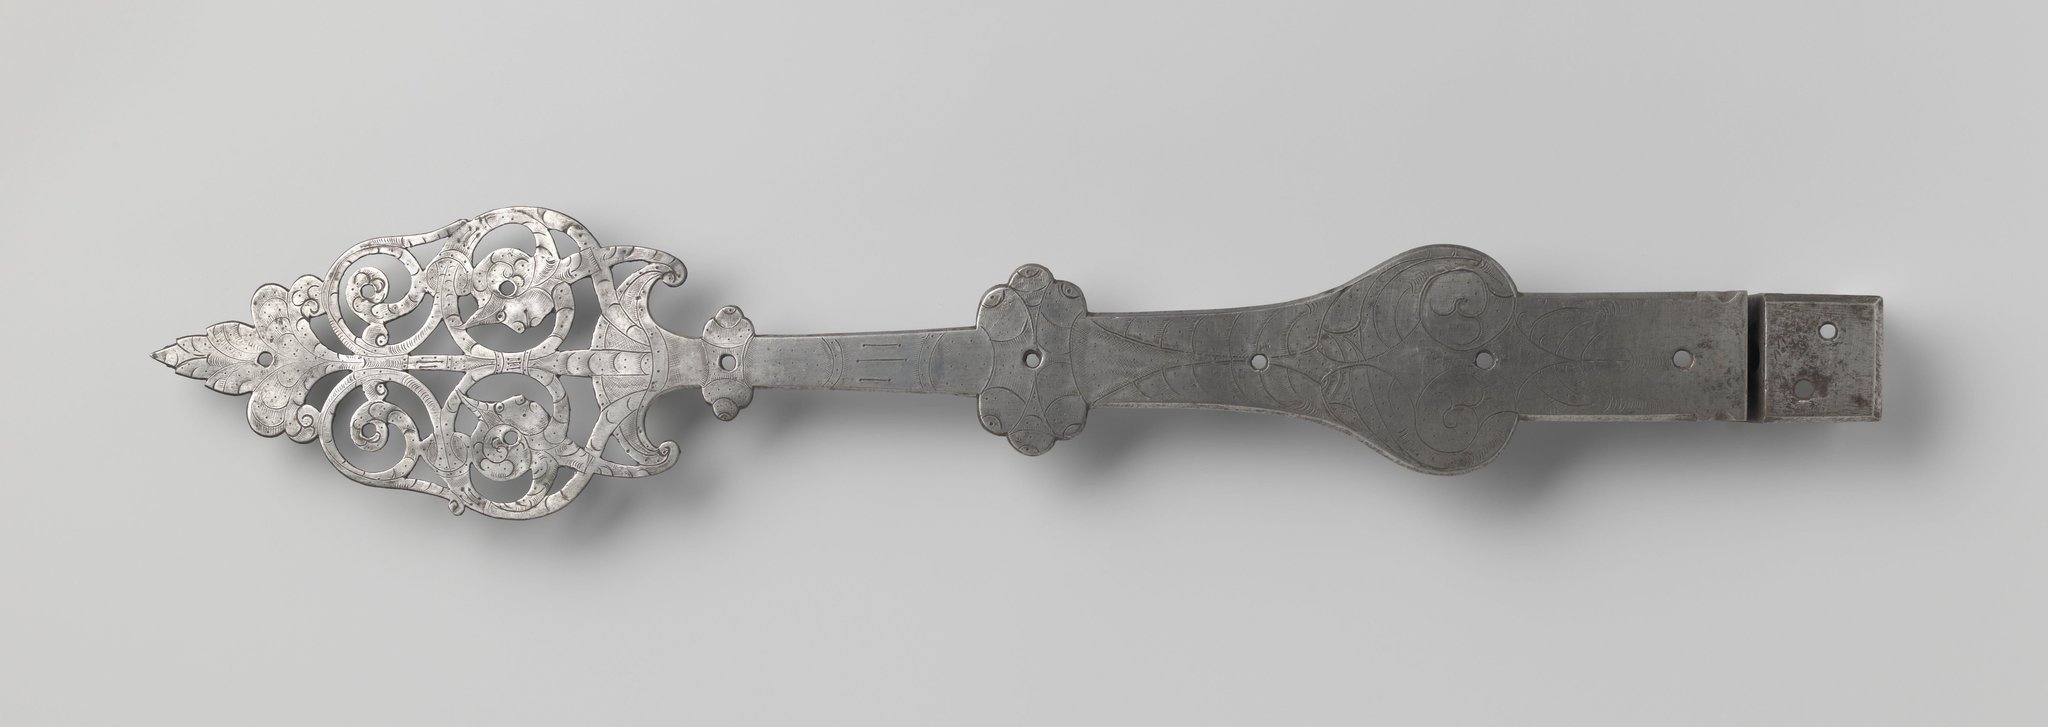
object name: door fitting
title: Deurhengsel van vertind ijzer, versierd met graveringen en narrenkoppen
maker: Anonymous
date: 1600-1700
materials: iron, tin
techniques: engraving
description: Deurhengsel van vertind ijzer versierd met graveringen. Het beslag is vanaf het scharnier als volgt: een balustervormig begin, overgaand in een smal, recht stuk waaruit naar het einde toe enkele bladmotieven ontspringen, die als voluten omkrullen. In het midden daarvan kijken twee narrenkoppen elkaar aan. Het geheel eindigt in een puntig blad.